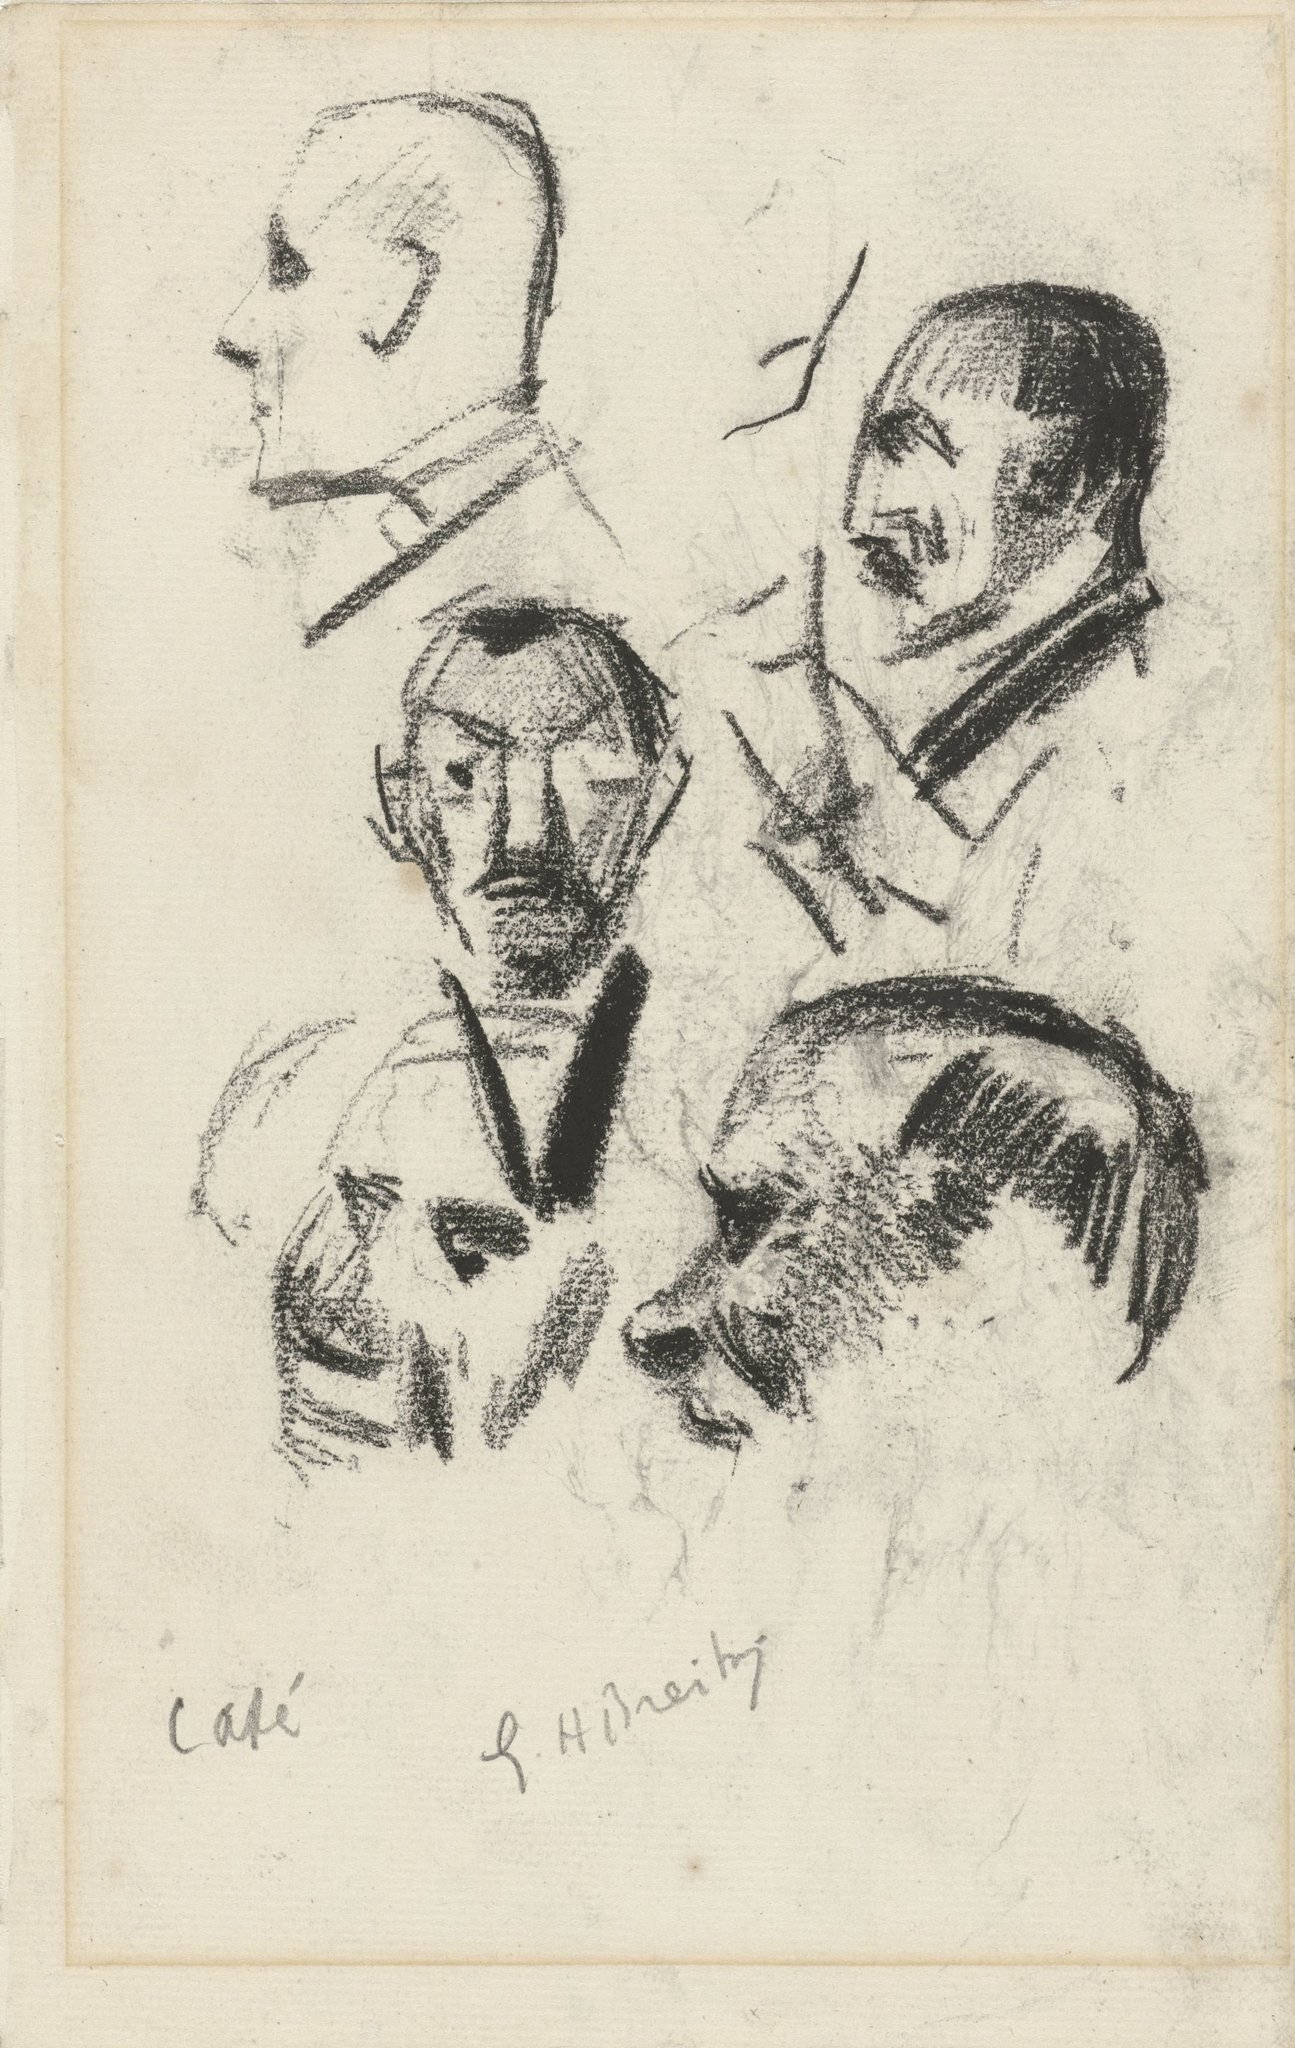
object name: drawing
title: Schetsen van cafébezoekers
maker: george hendrik breitner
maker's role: draughtsman, painter, print maker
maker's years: 1857-1923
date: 1867-1923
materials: chalk, paper